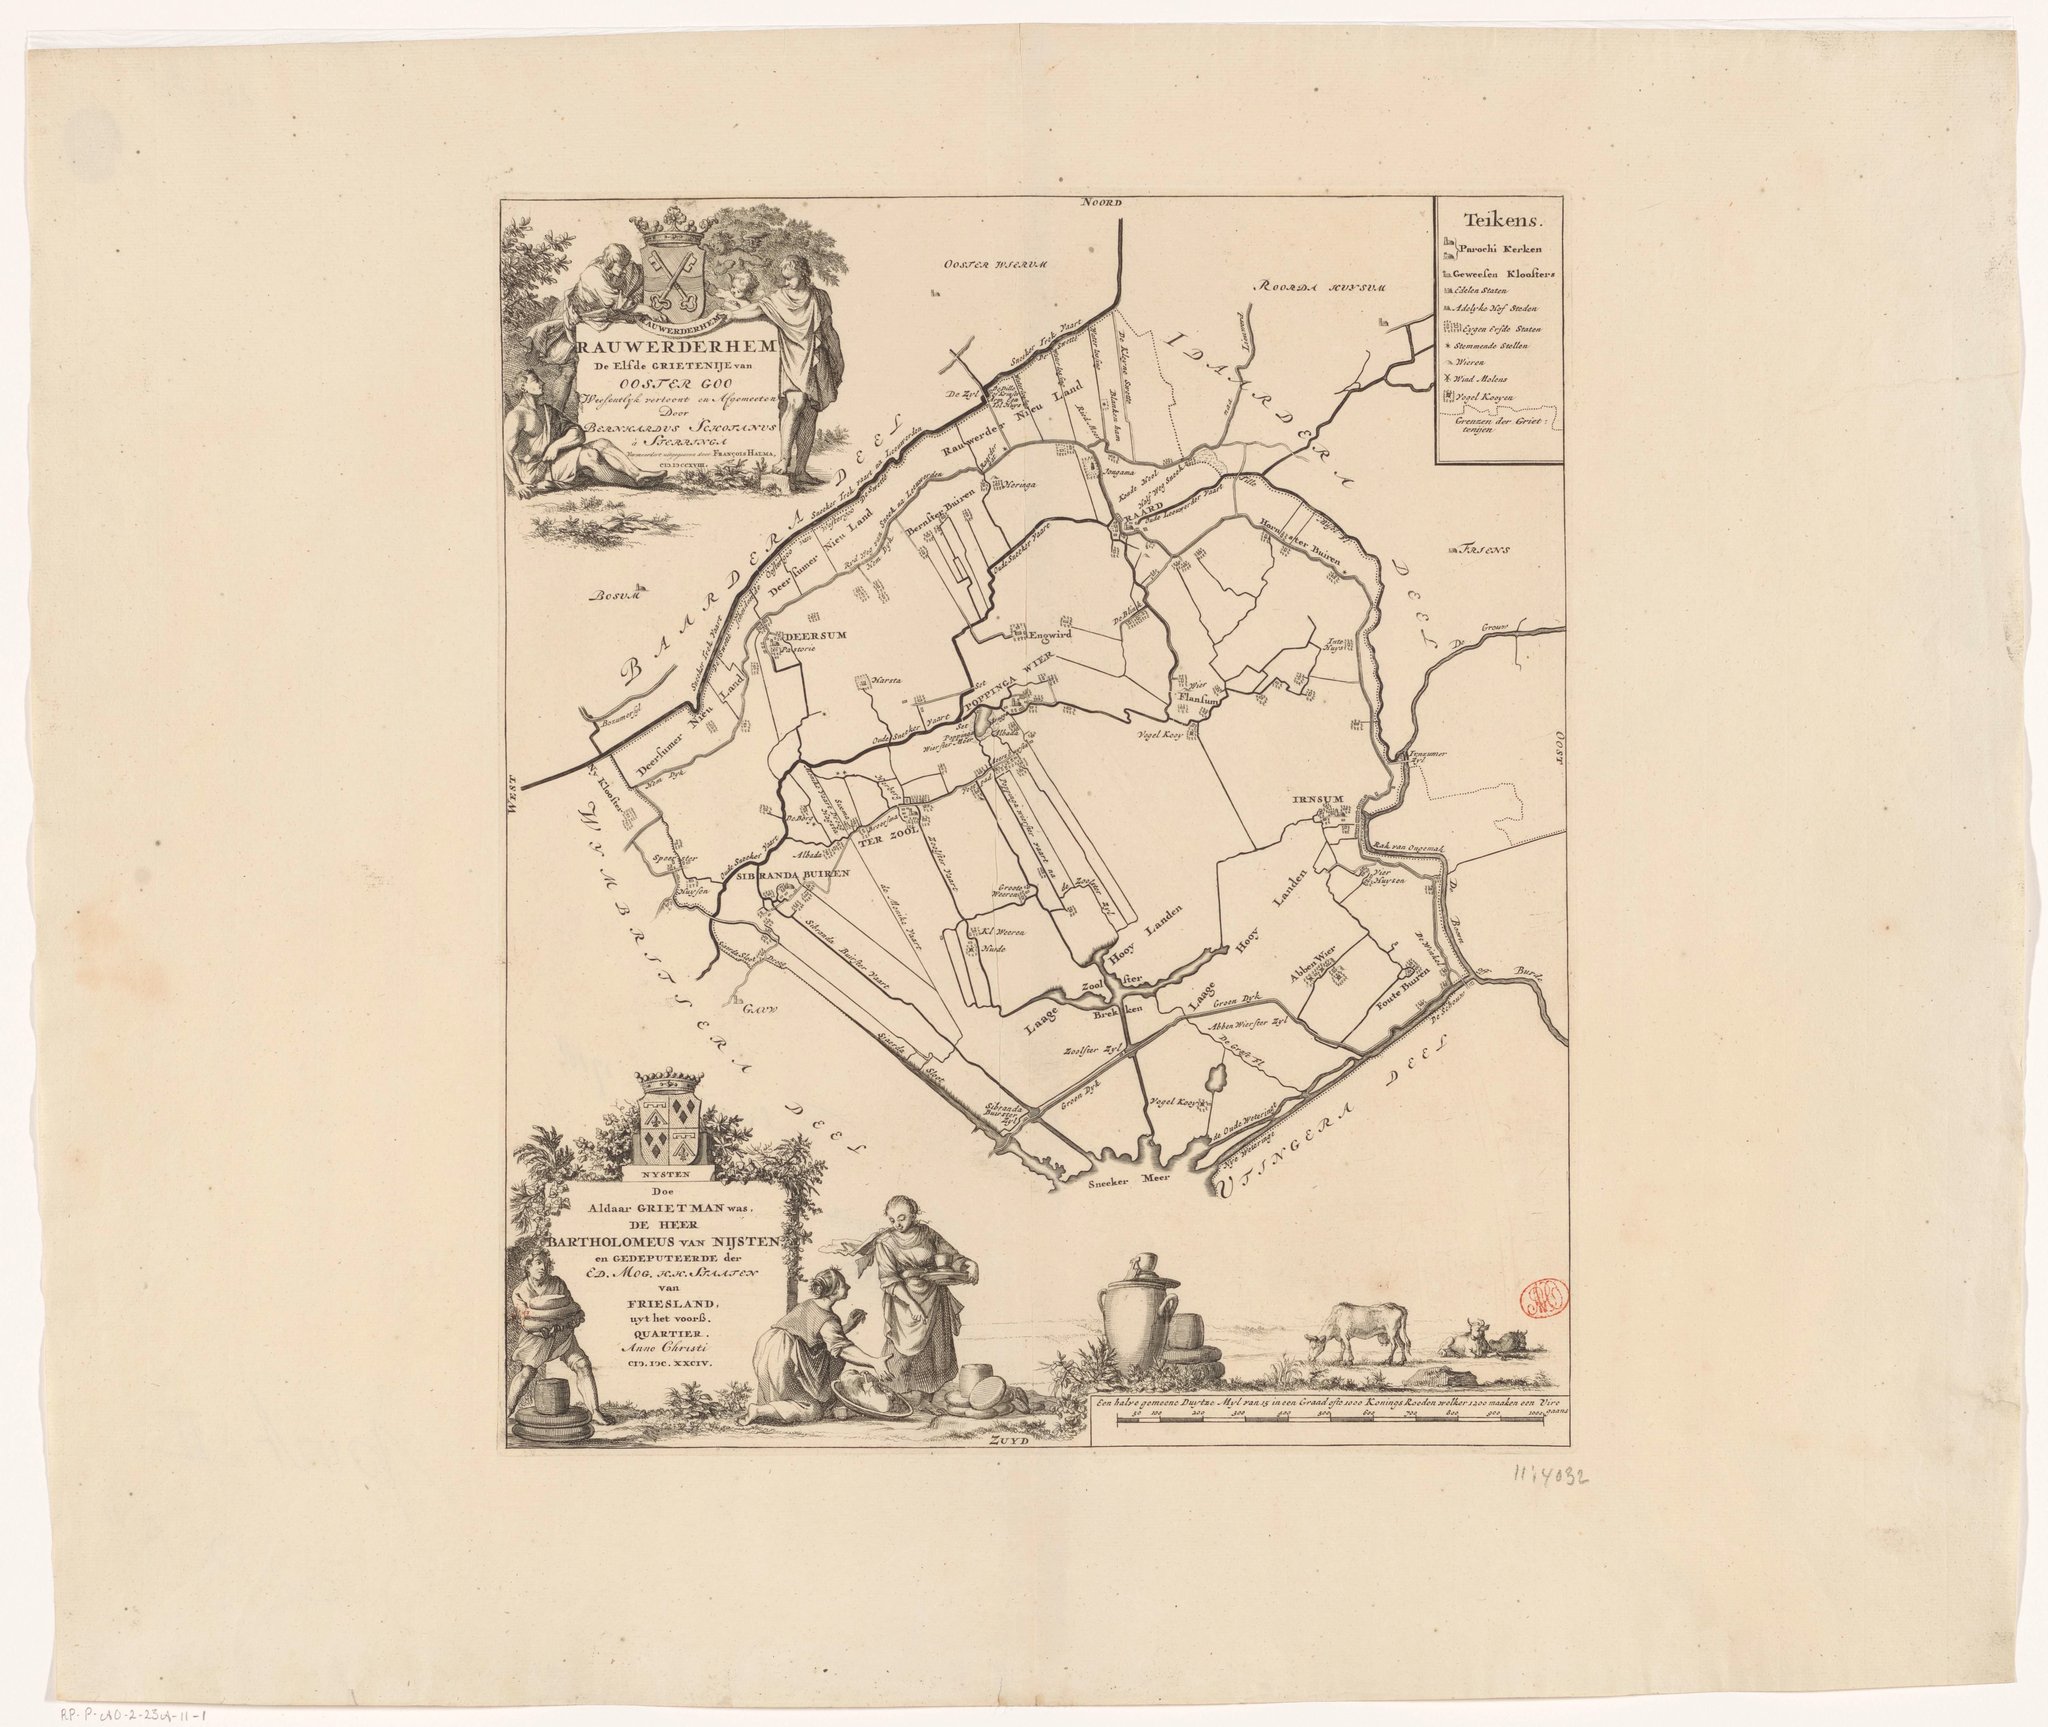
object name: map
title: Rauwerderhem de elfde grietenije van Ooster goo (...)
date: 1698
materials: paper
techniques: engraving, etching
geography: friesland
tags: coat of arms (as symbol of the state, etc.), maps of separate countries or regions, butter, cheese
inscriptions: collector's mark: Lugt 2228, label: ‘264’, collector's mark: Lugt 195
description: Linksboven titelcartouche, daaromheen een aantal mannen en putti en het wapen van Rauwerderhem. Linksonder cartouche met bestuurlijke informatie over de grietenij, daaromheen het wapen van grietman Bartholomeus van Nysten en een jongen en vrouwen met kazen en boter. Rechtsboven legenda, rechtsonder een schaalstok: Een halve gemeene Duytze myl van 15 in een graad ofte 1000 konings roeden welker 1200 maaken een uire gaans.